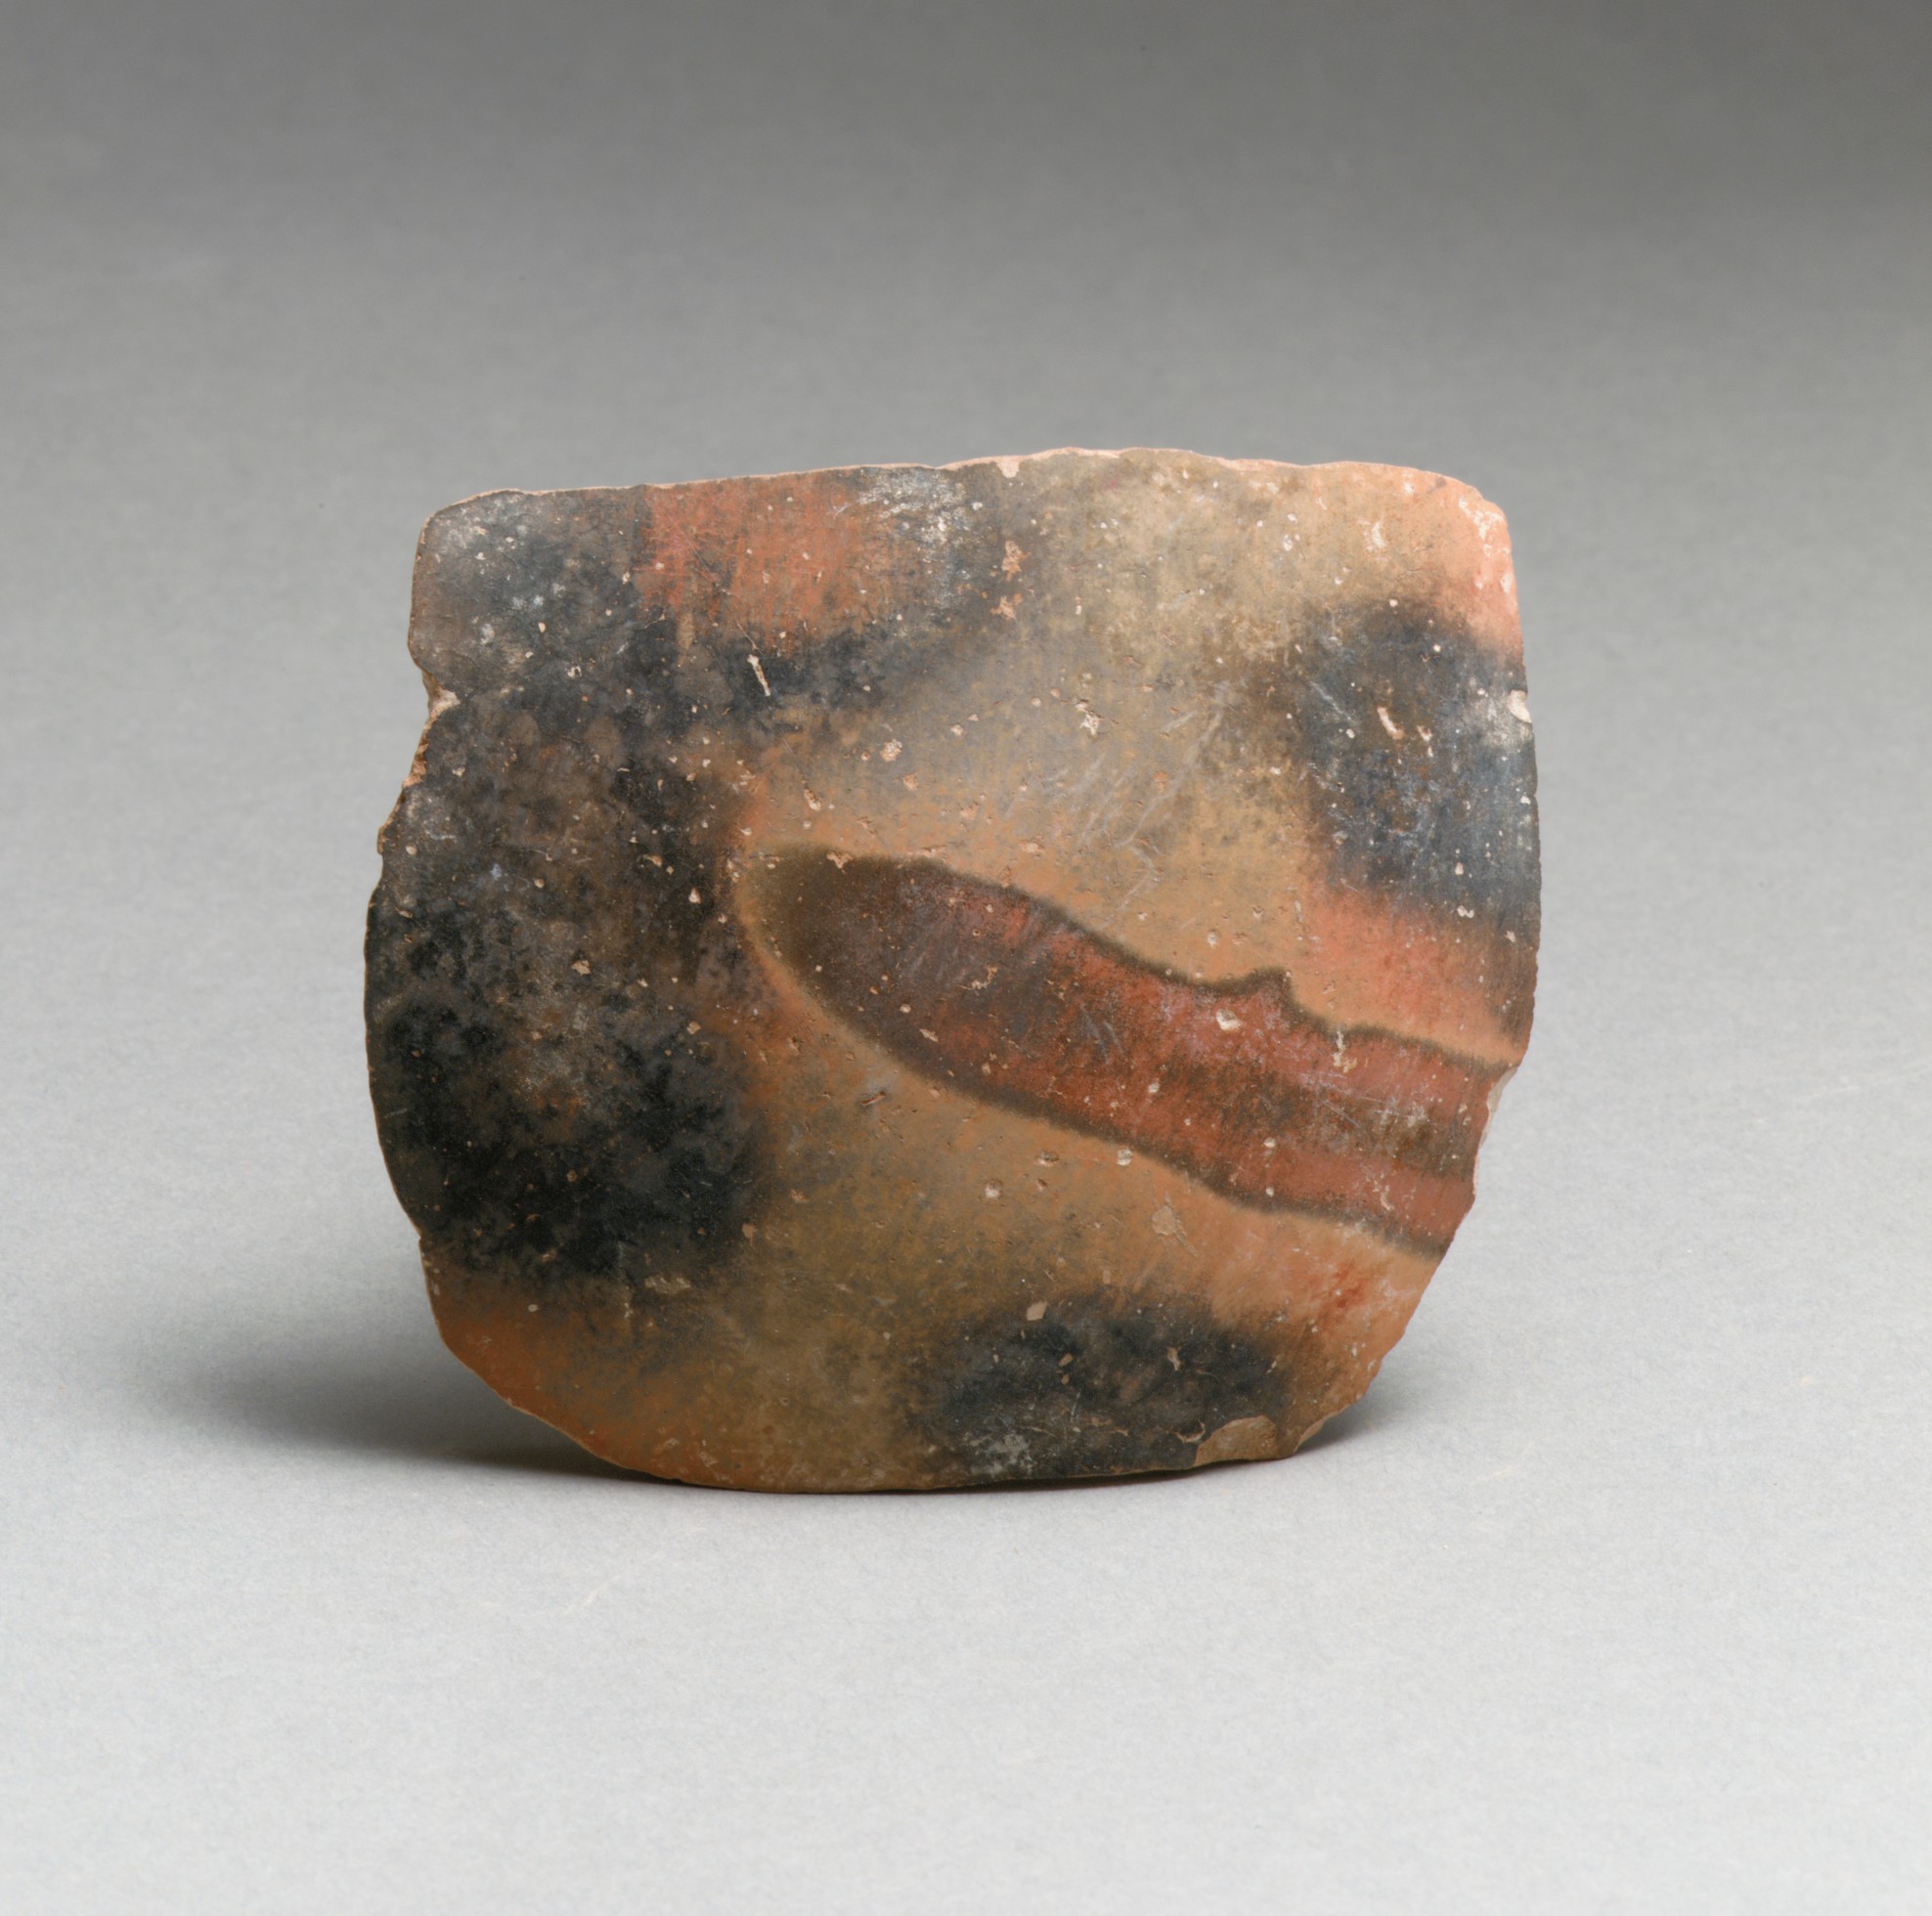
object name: vase fragment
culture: minoan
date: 2600-2000 BCE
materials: terracotta